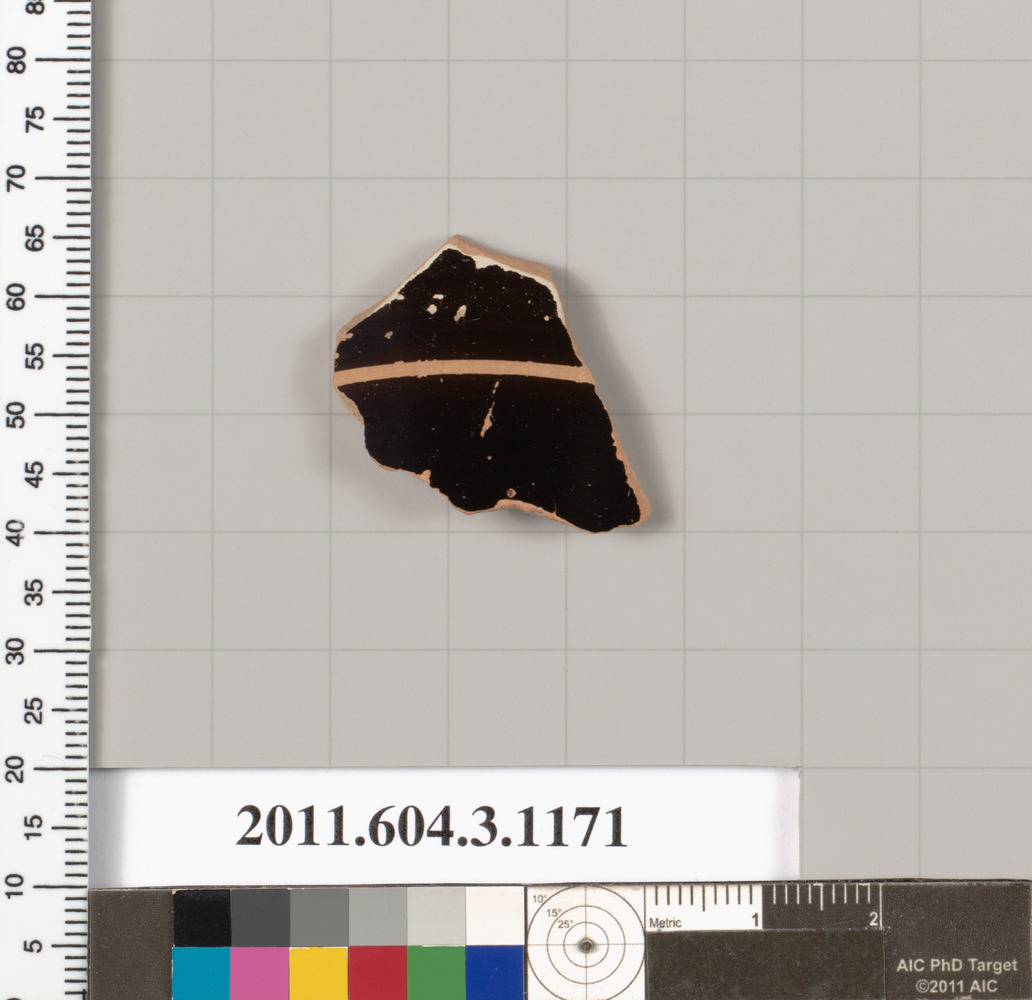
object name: mastoid or kyathos fragment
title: Terracotta fragment of a mastoid (drinking cup with narrow base) or a kyathos (cup-shaped ladle)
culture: greek, attic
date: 534-468 BCE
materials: terracotta